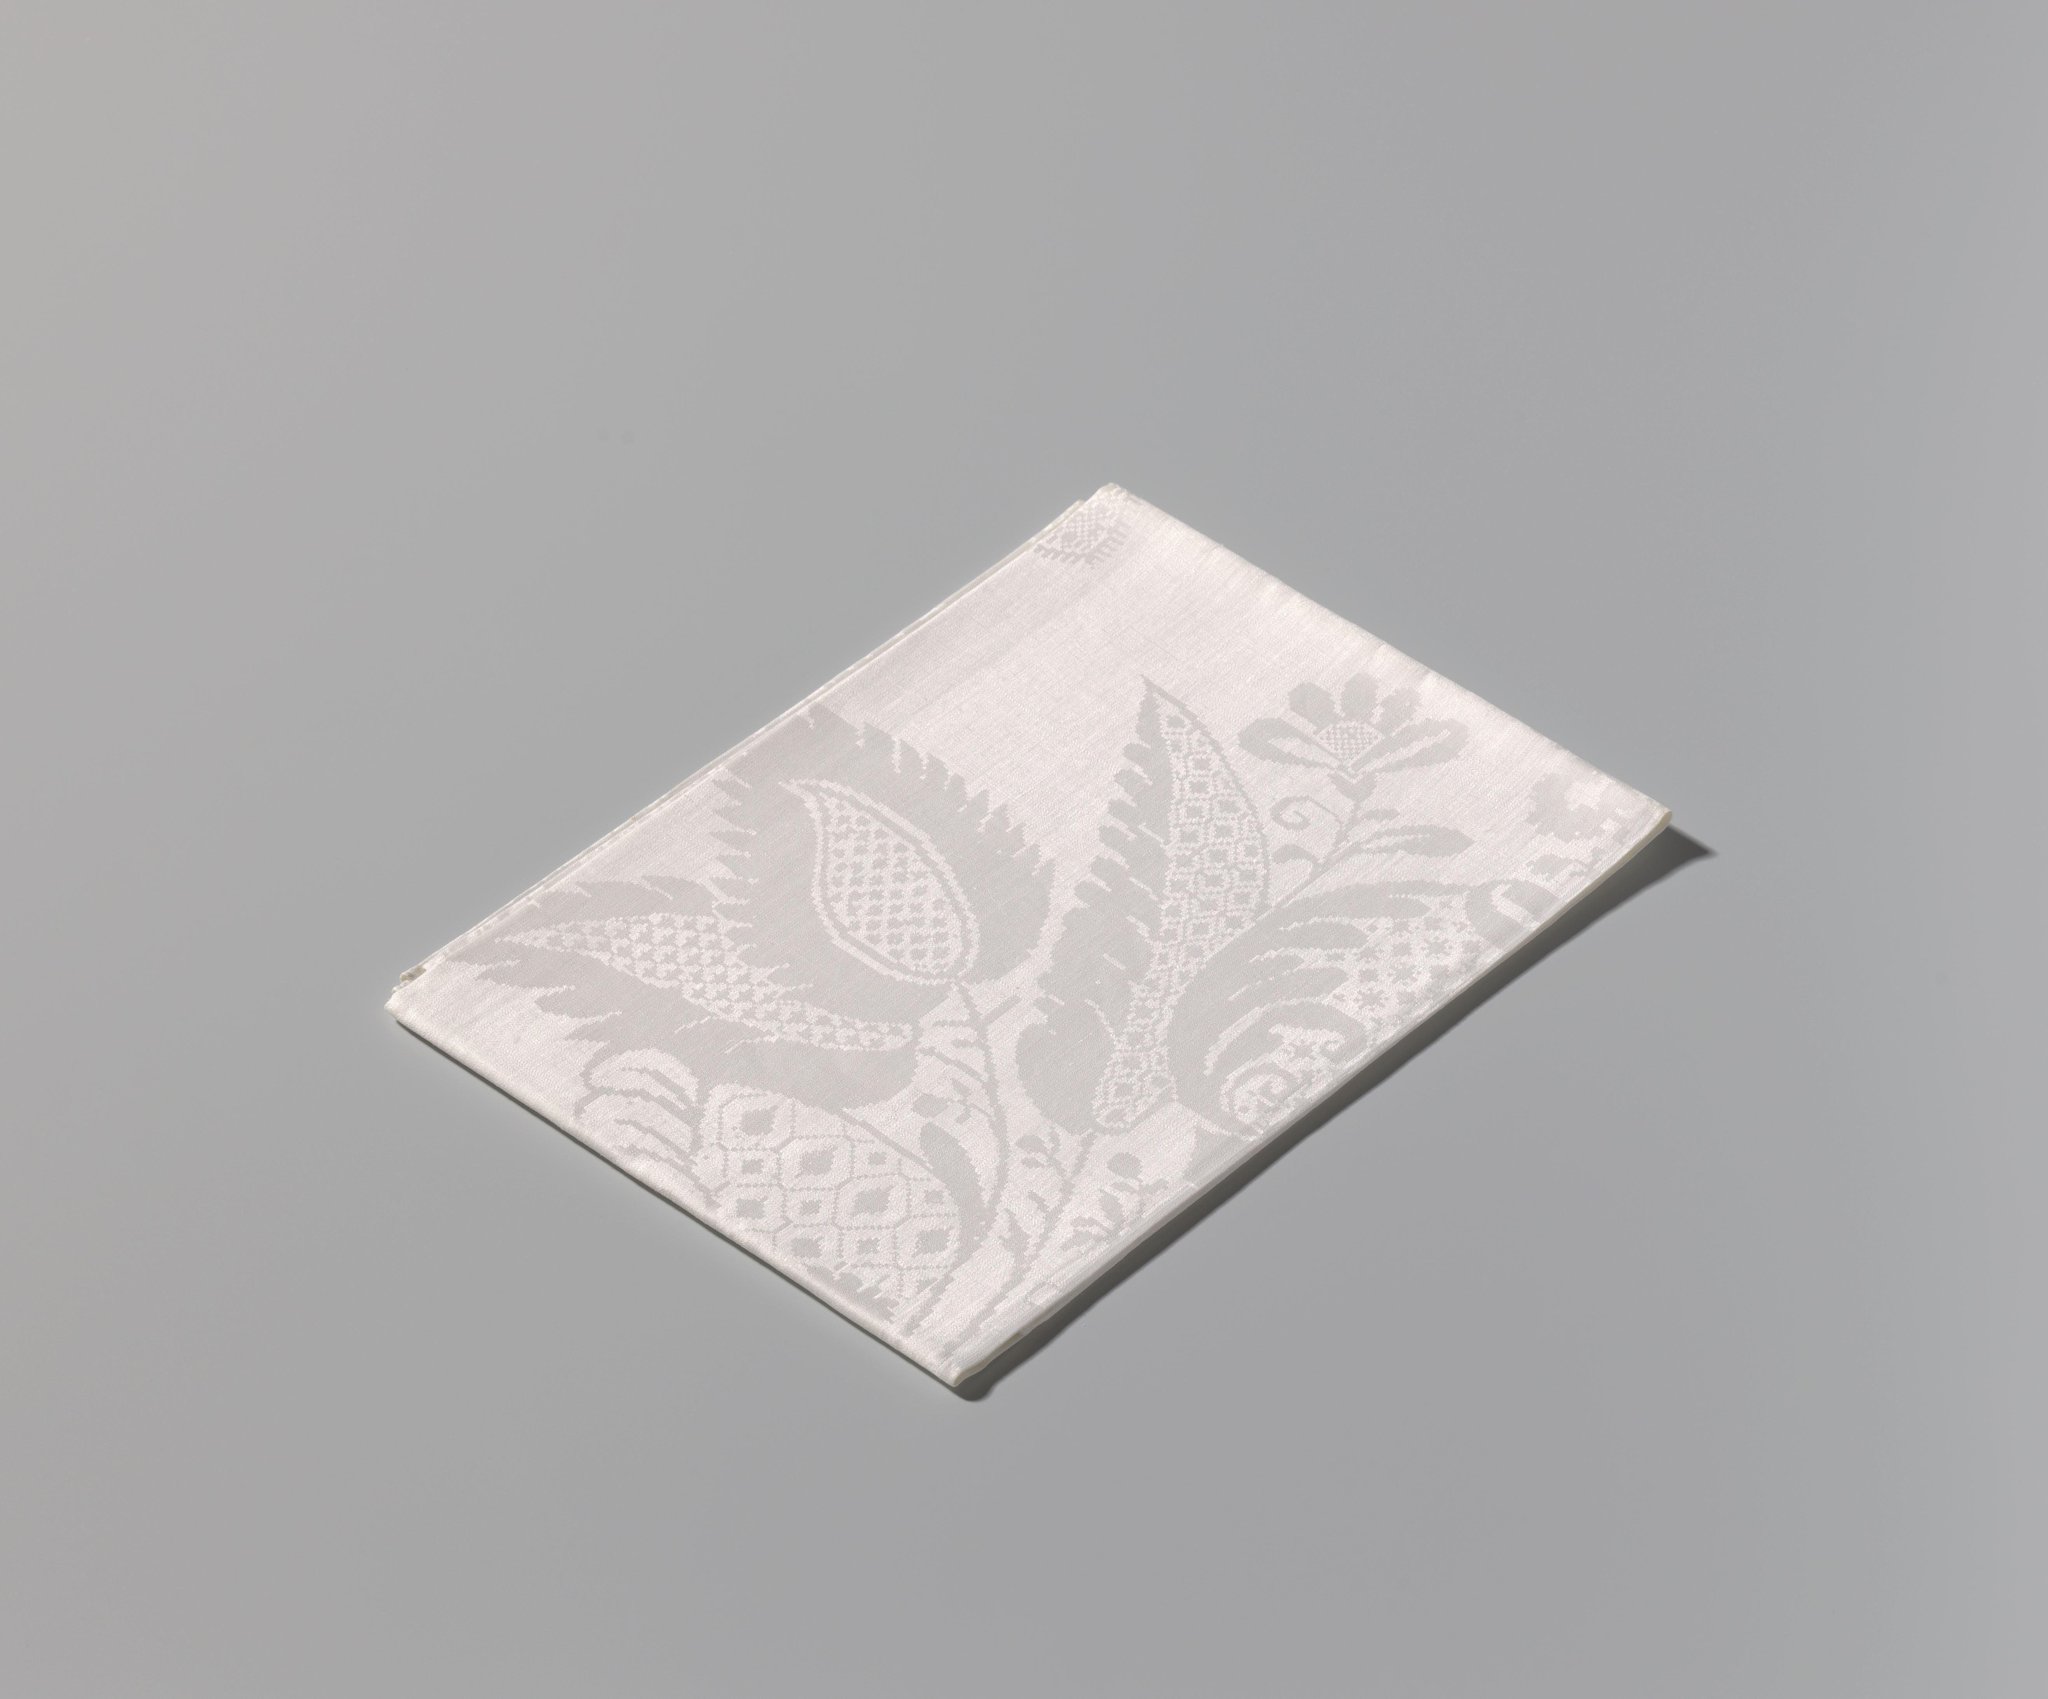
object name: napkin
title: Servet met een bloemboeket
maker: Anonymous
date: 1700-1749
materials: linen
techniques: damask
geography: netherlands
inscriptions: mark: ‘HP’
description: Servet van linnendamast. Ovale velden met binnenwaartse spits geschulpte rand dragen een bloemboeket van verbasterde granaatappel, voortkomende uit een afgeplatte bolvorm met schutbladeren. Binnenvullingen van rasterwerk. op de raakpunten rozetten, in de zwikken losse bloemtakken. twee smalle randen, de binnenste met dubbele rij aaneengeregen achthoekjes met stermotief, de buitenste met lopende bloemrank. Rondom een T-rand.